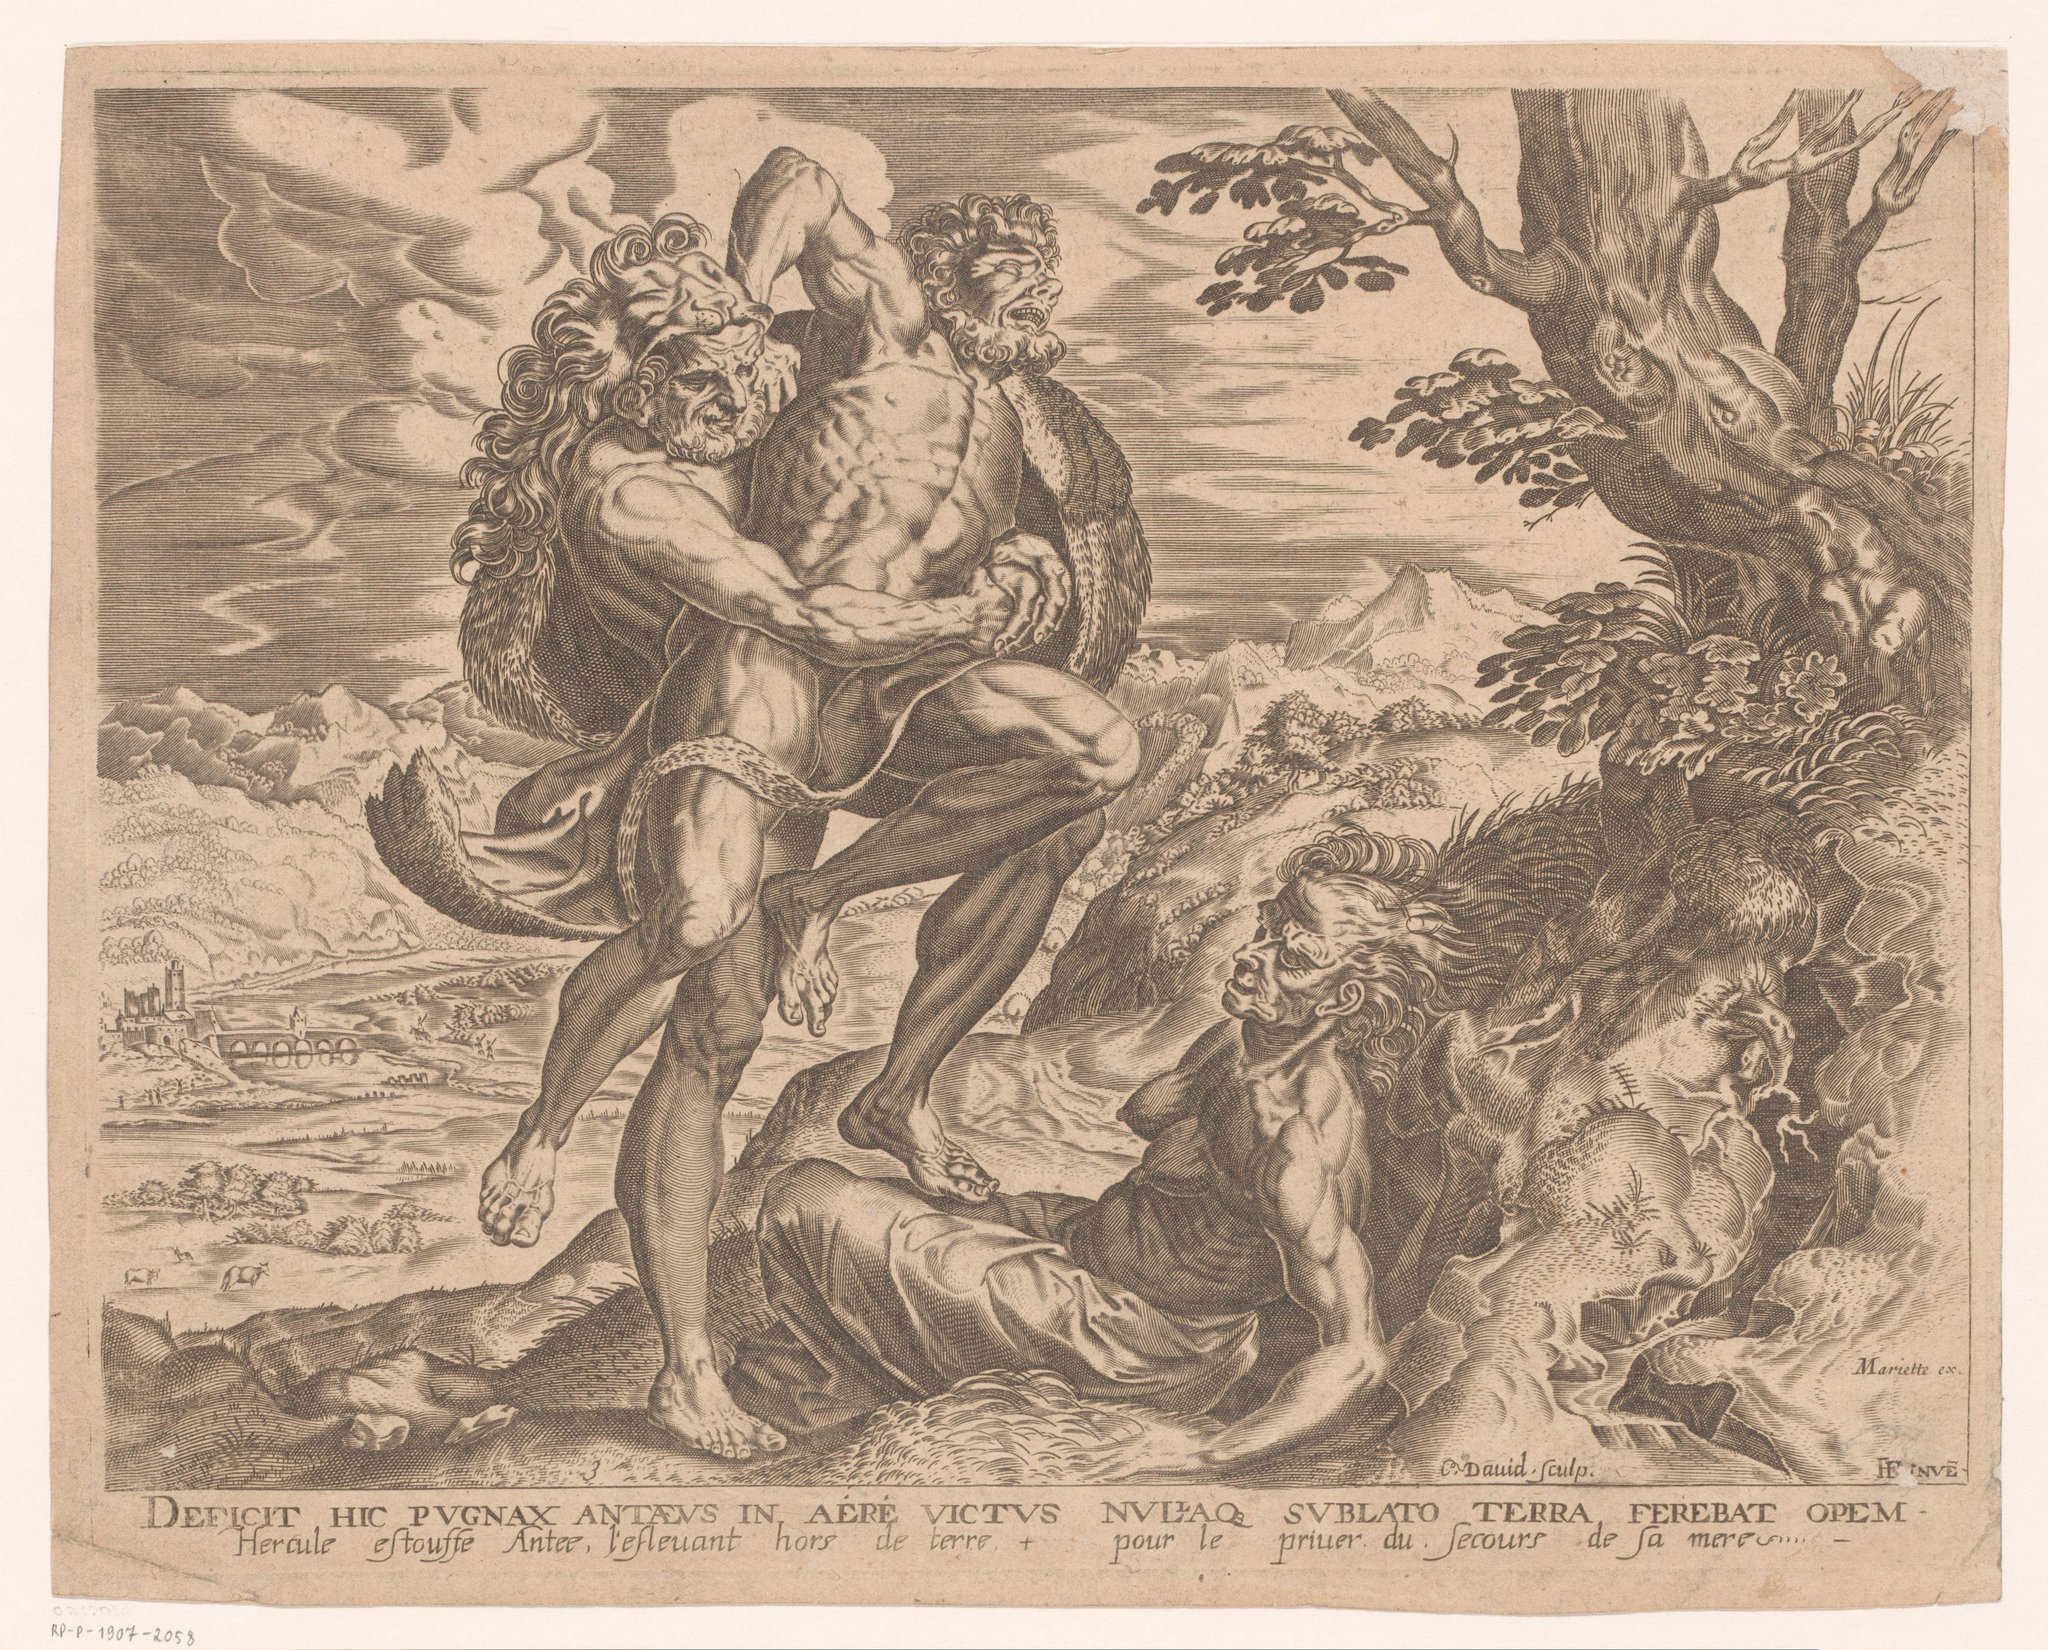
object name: print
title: Hercules worstelt met Antaeus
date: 1613-1638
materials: paper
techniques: engraving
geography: france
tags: the giant antaeus is lifted in the air and crushed to death by hercules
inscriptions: collector's mark: Lugt 2228